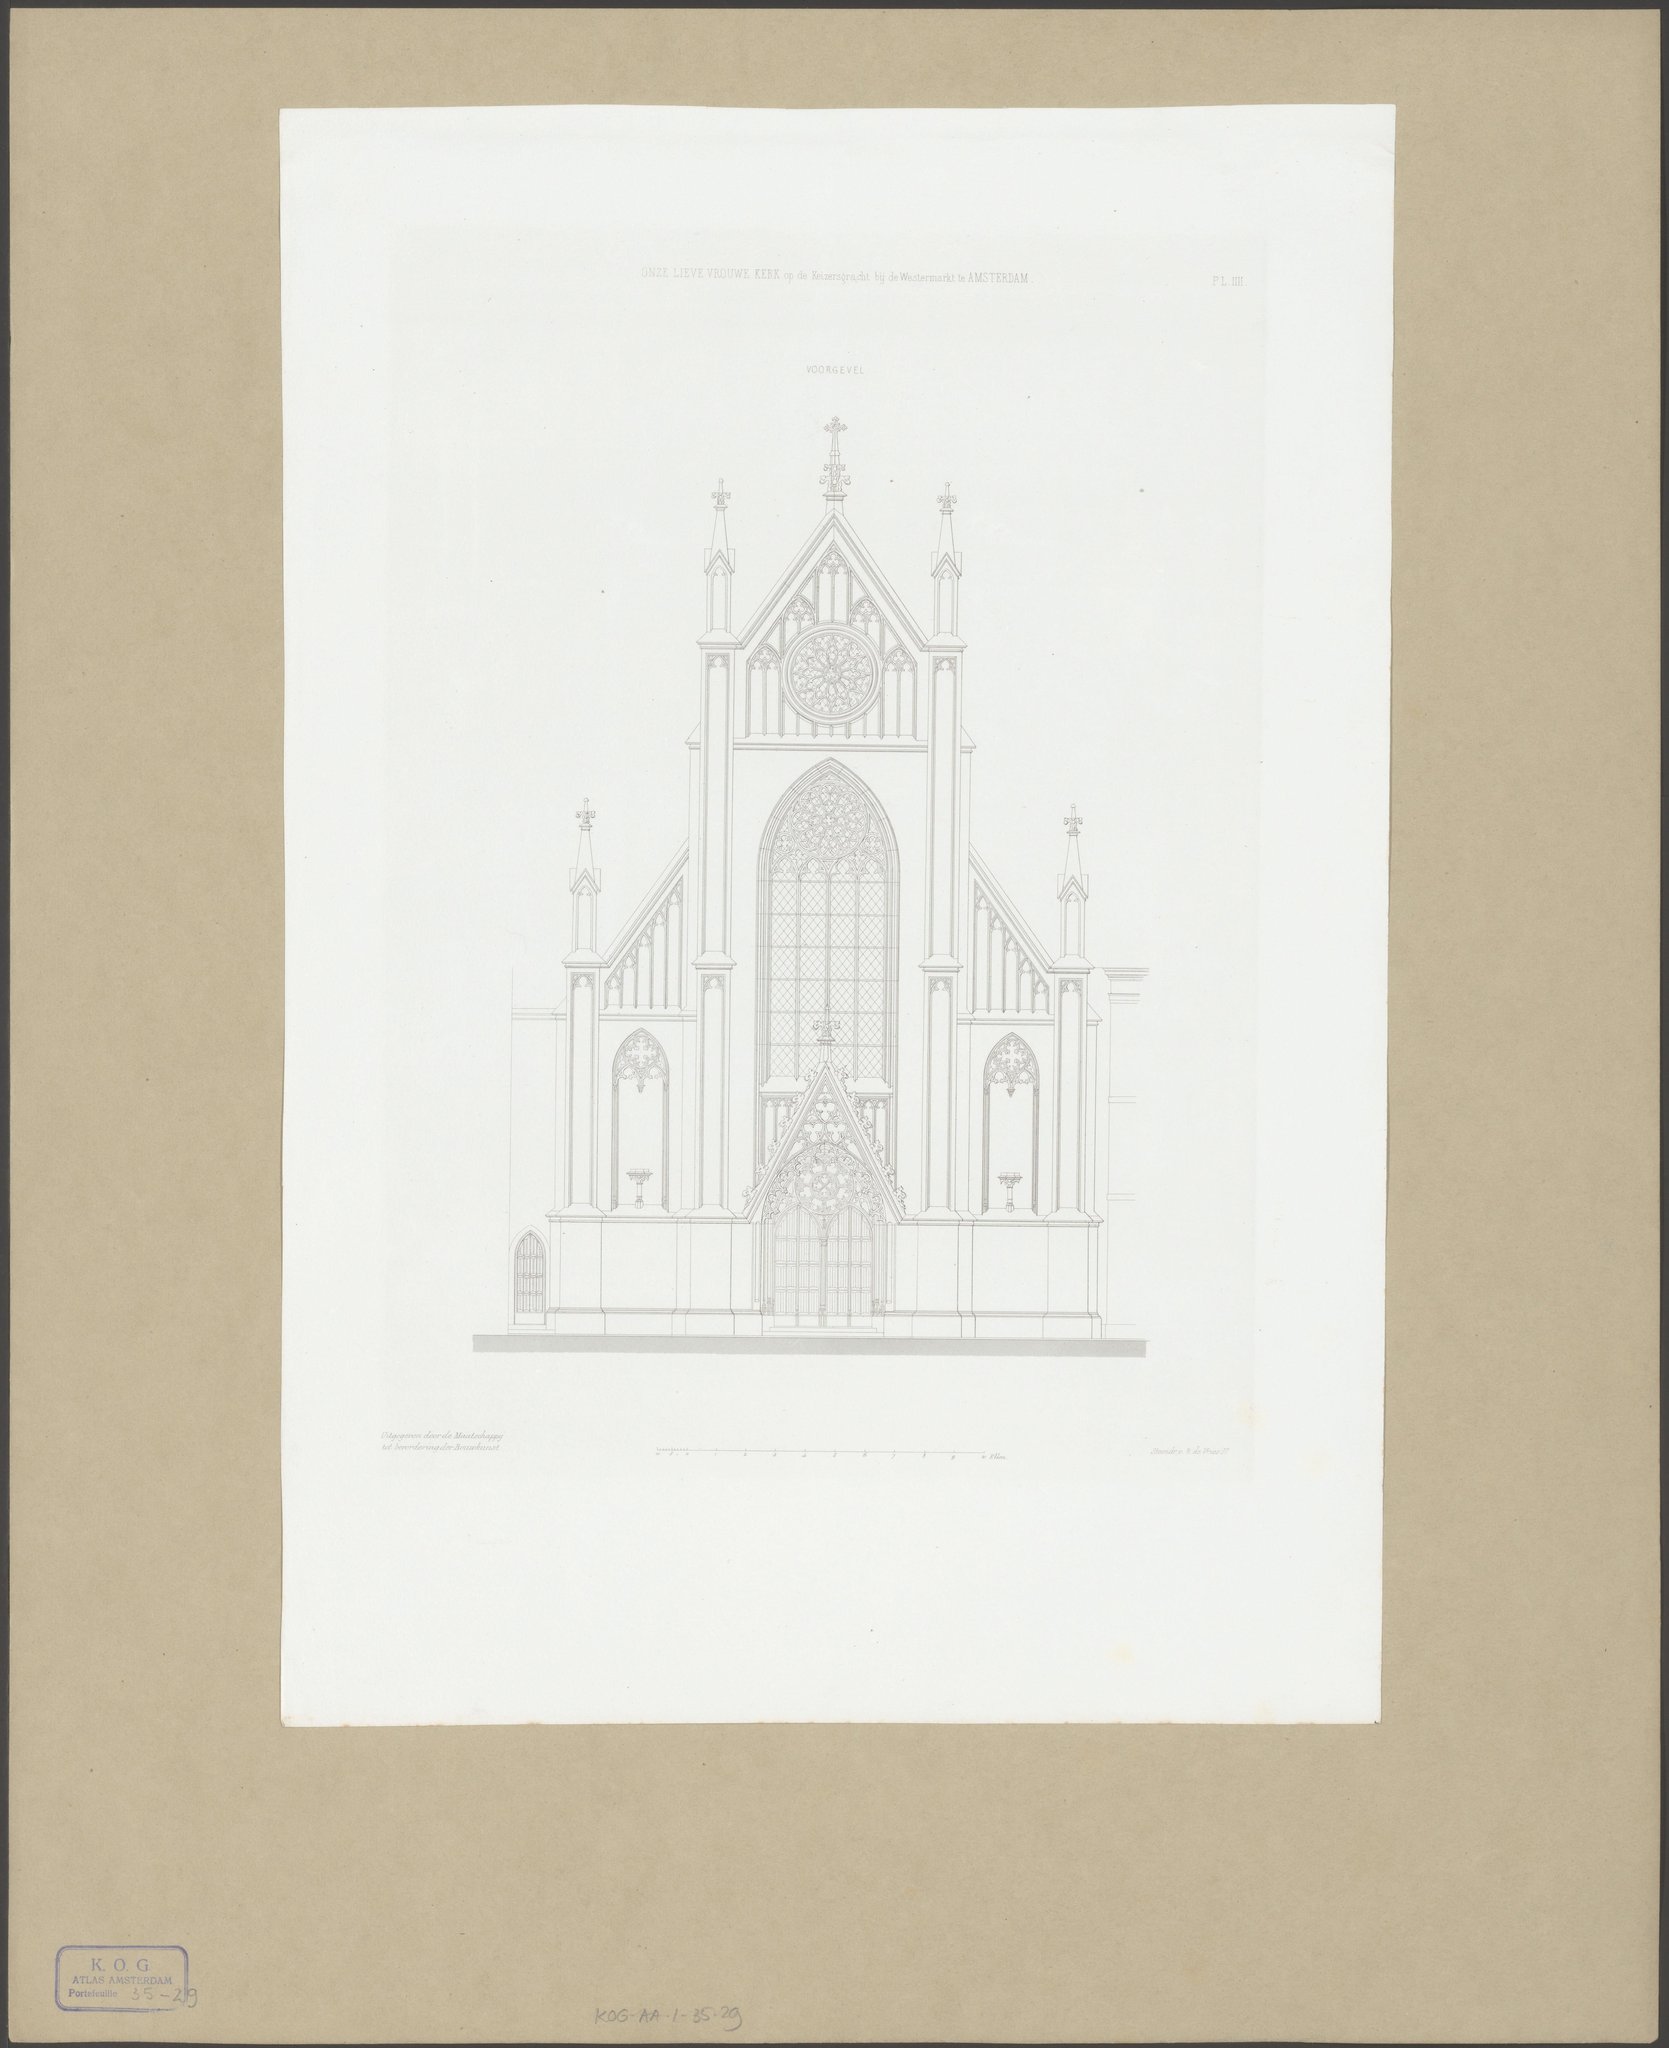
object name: print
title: Gevelaanzicht van de Onze-Lieve-Vrouwekerk te Amsterdam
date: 1856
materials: paper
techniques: lithograph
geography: amsterdam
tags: roman catholic church, parts of church exterior and annexes: façade, plan ~ architecture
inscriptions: collector's mark: ‘35-29’ Lugt 1641b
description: Rechtsboven genummerd: PL.IIII. Onderaan een schaalroede. Onderwerpsrubriek binnen de Atlas Amsterdam: R.K. Gemeenten: Sint Nicolaaskerk t/m Willibrordus (Rustenburgerstraat).